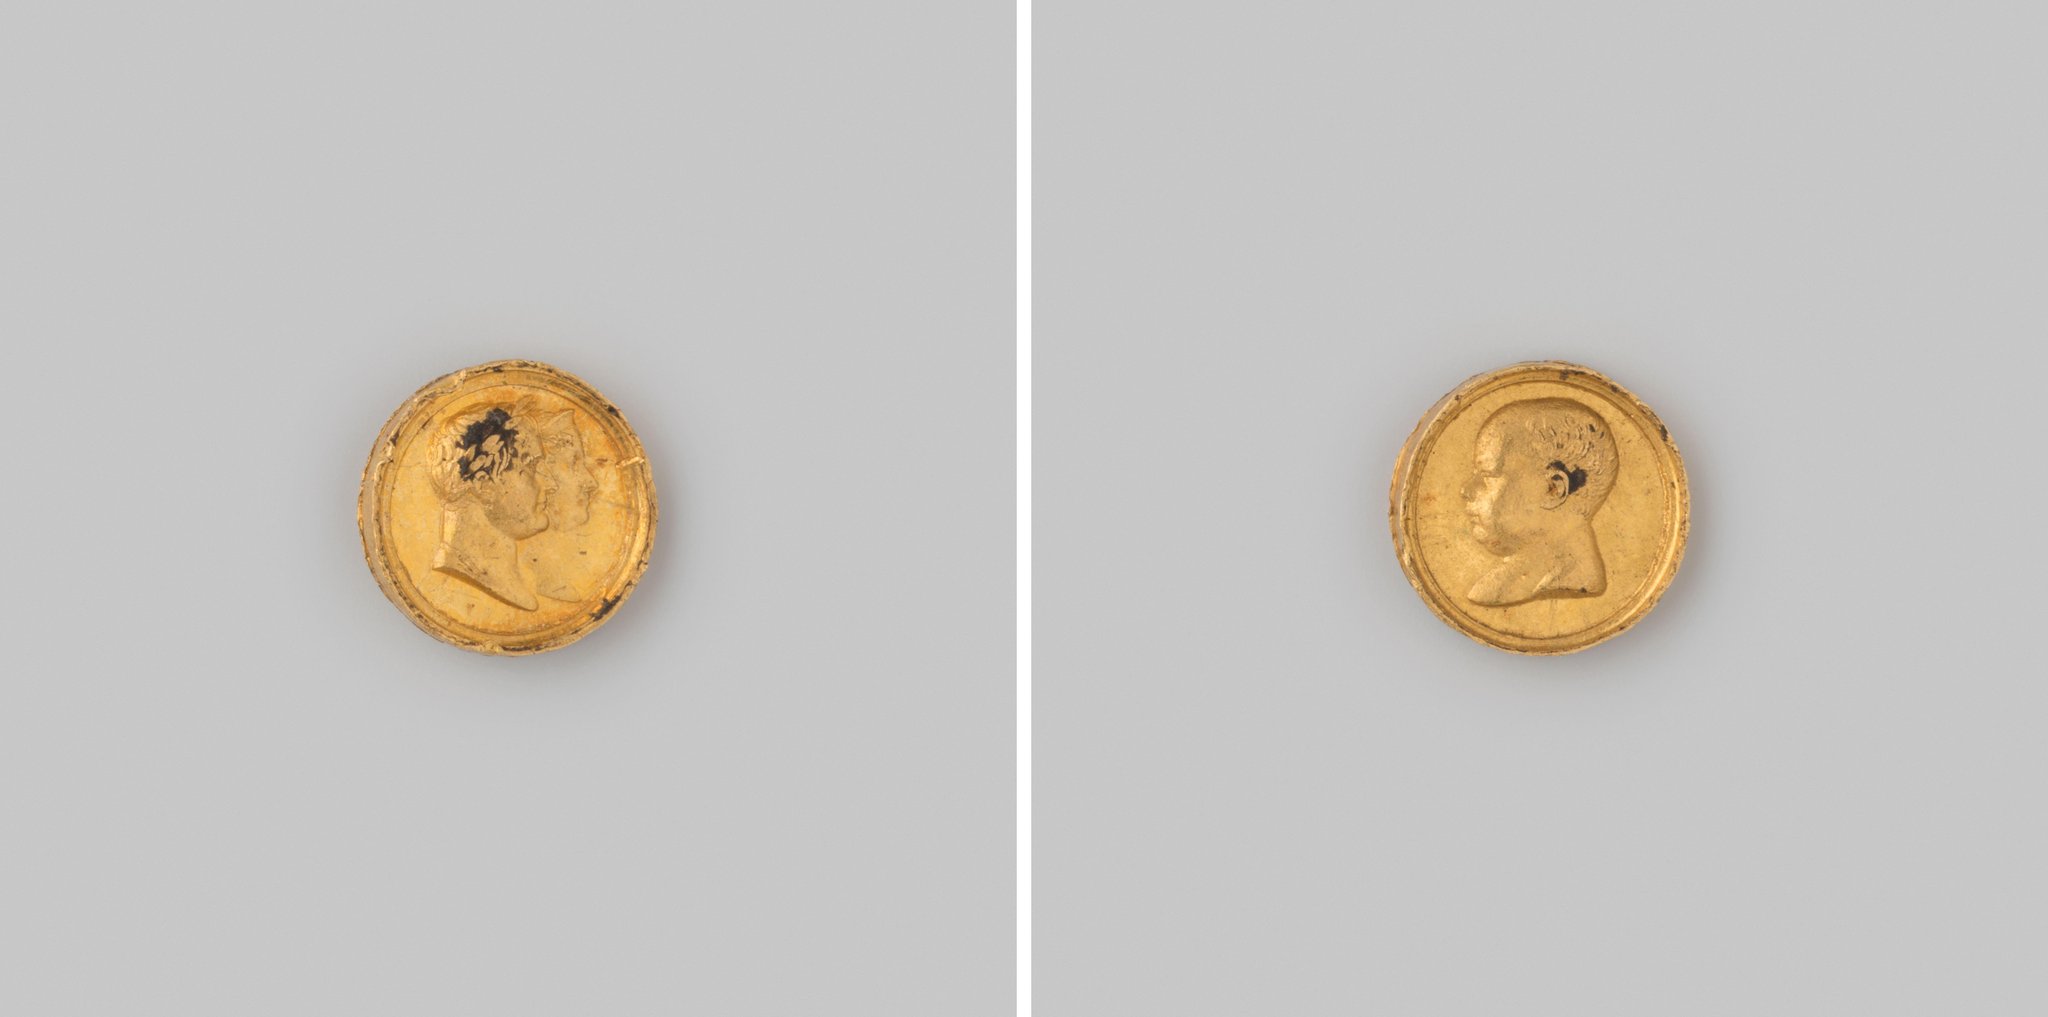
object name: strooipenning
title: Geboorte van Napoleon Frans Karel Jozef, zoon van Napoleon I Bonaparte en Marie Louise, keizer en keizerin der Fransen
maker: Anonymous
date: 1811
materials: gold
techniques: striking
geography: paris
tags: paris, vienna, napoleon i (emperor of the french), marie louise van oostenrijk (keizerin der fransen)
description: Gouden penning. Voorzijde: borststuk man met lauwerkrans en vrouw met diadeem. Keerzijde: borststuk kind